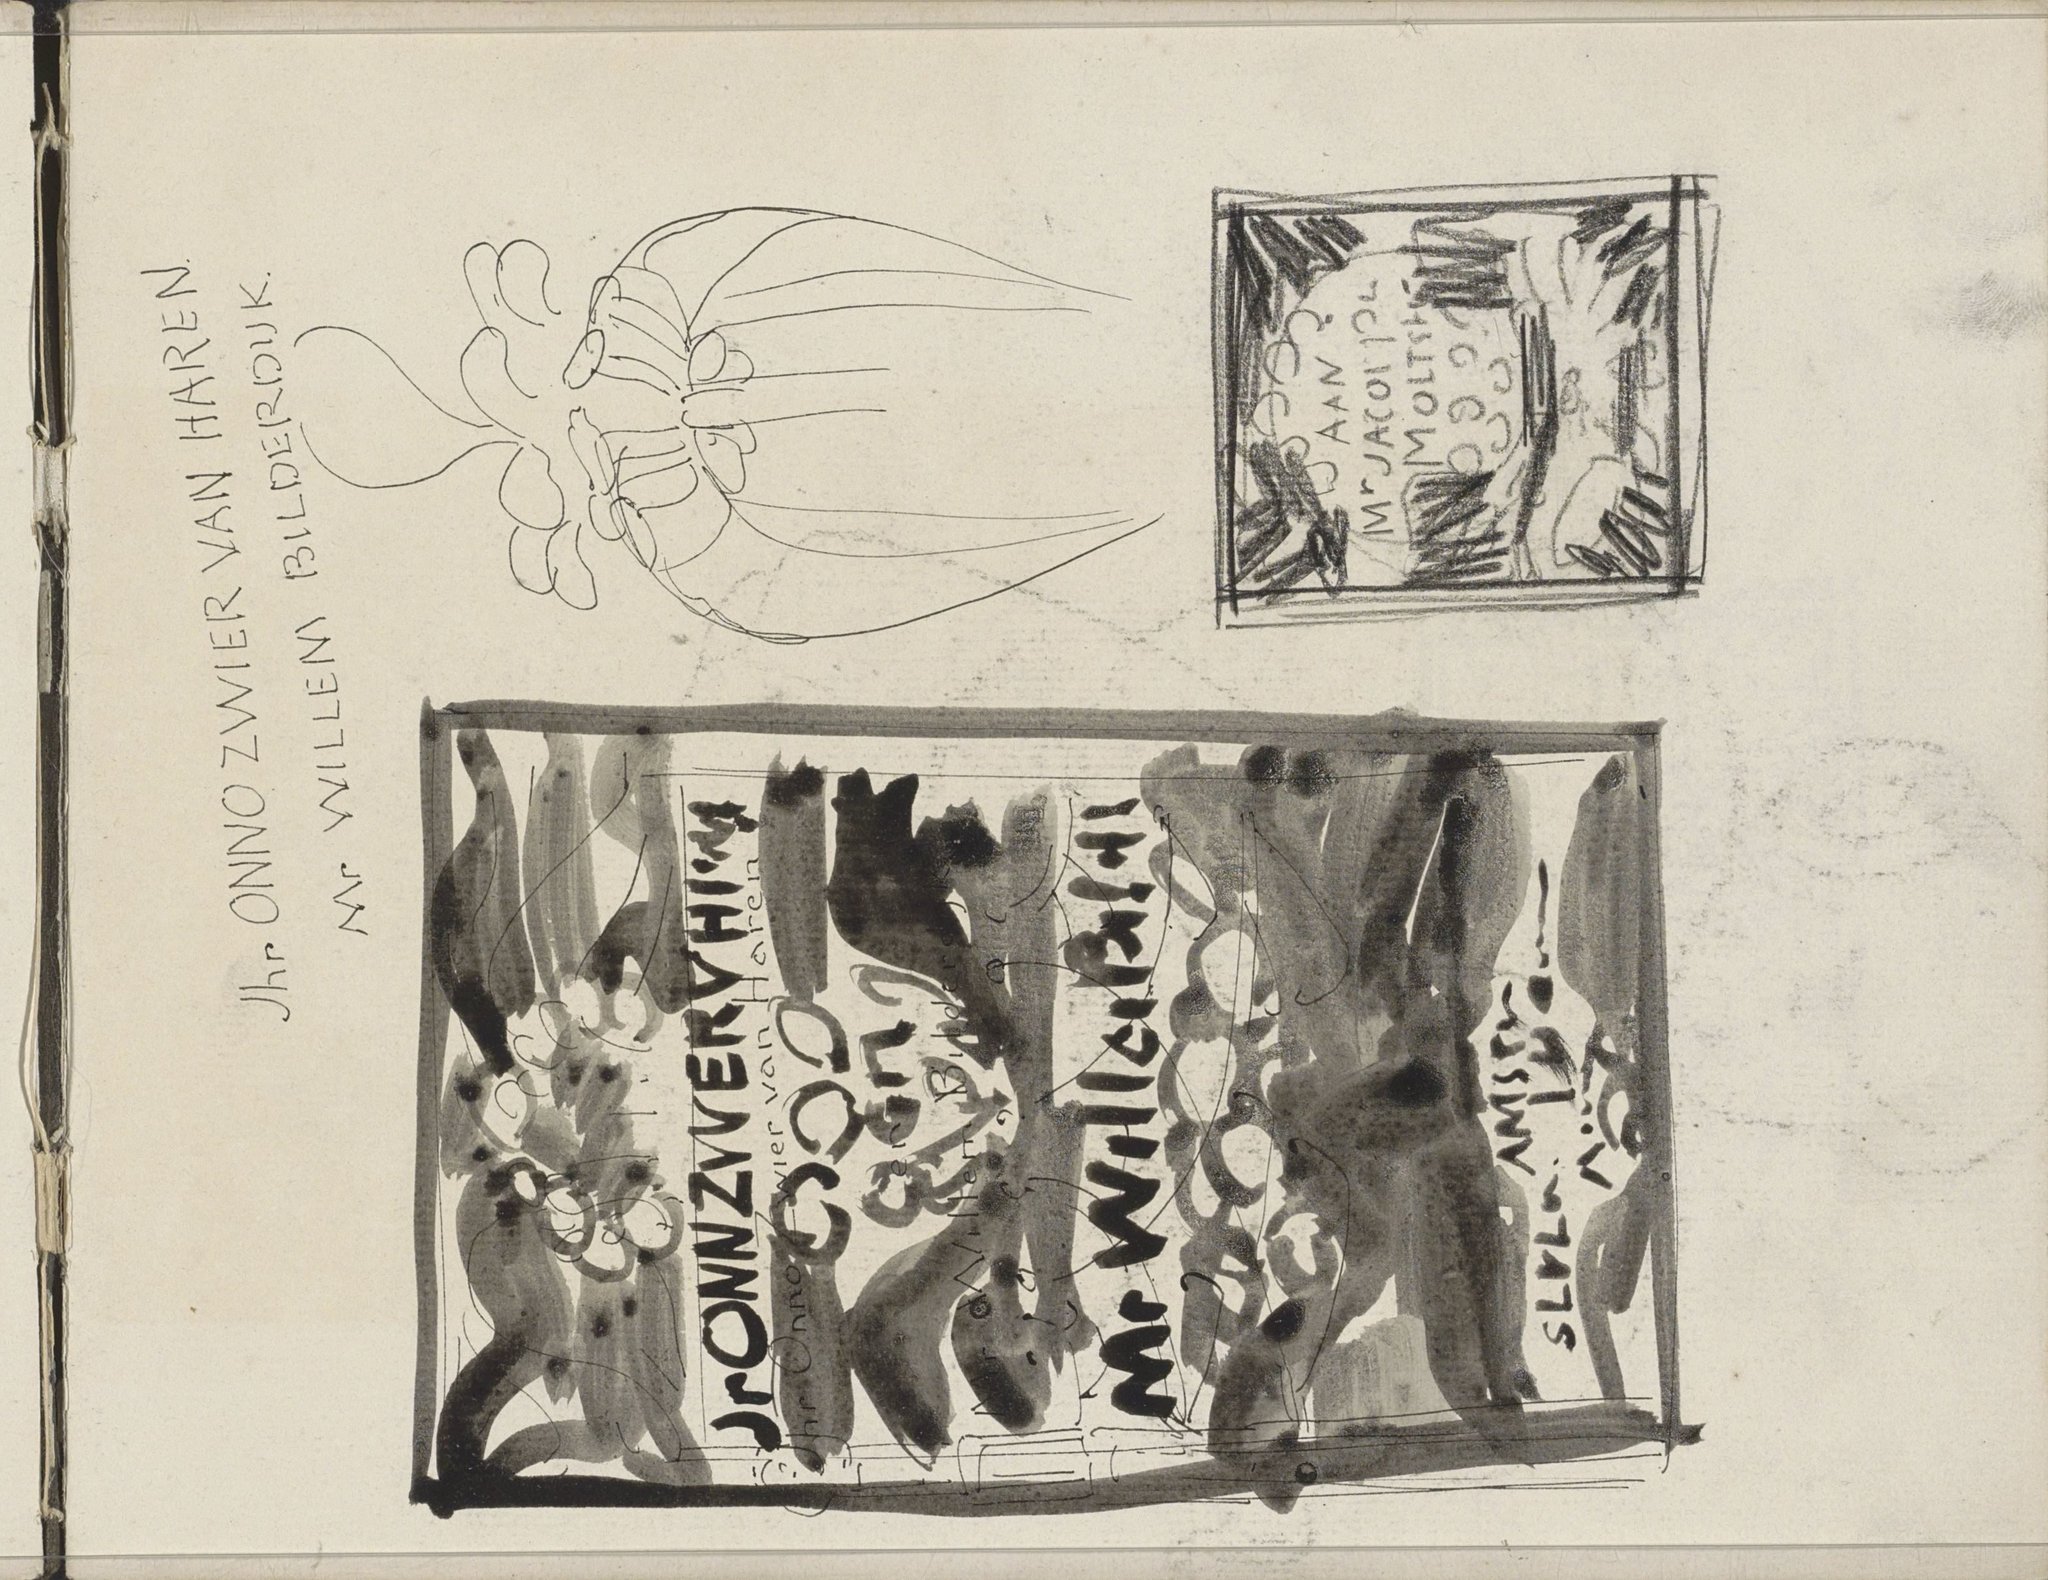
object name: sketchbook leaf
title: Ontwerp voor een boekomslag voor een werk van Bilderdijk en Zwier van Haren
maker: carel adolph lion cachet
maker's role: draughtsman, print maker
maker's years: 1864-1945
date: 1896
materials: chalk, ink, paper, watercolor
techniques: brush, pen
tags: book-cover, binding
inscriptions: annotation: ‘Jhr ONNO ZWIER VAN HAREN/ Mr WILLEM BILDERDIJK/ AAN MR Jaco[...]/ Moltst’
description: Blad 13 recto uit een schetsboek met 44 bladen.